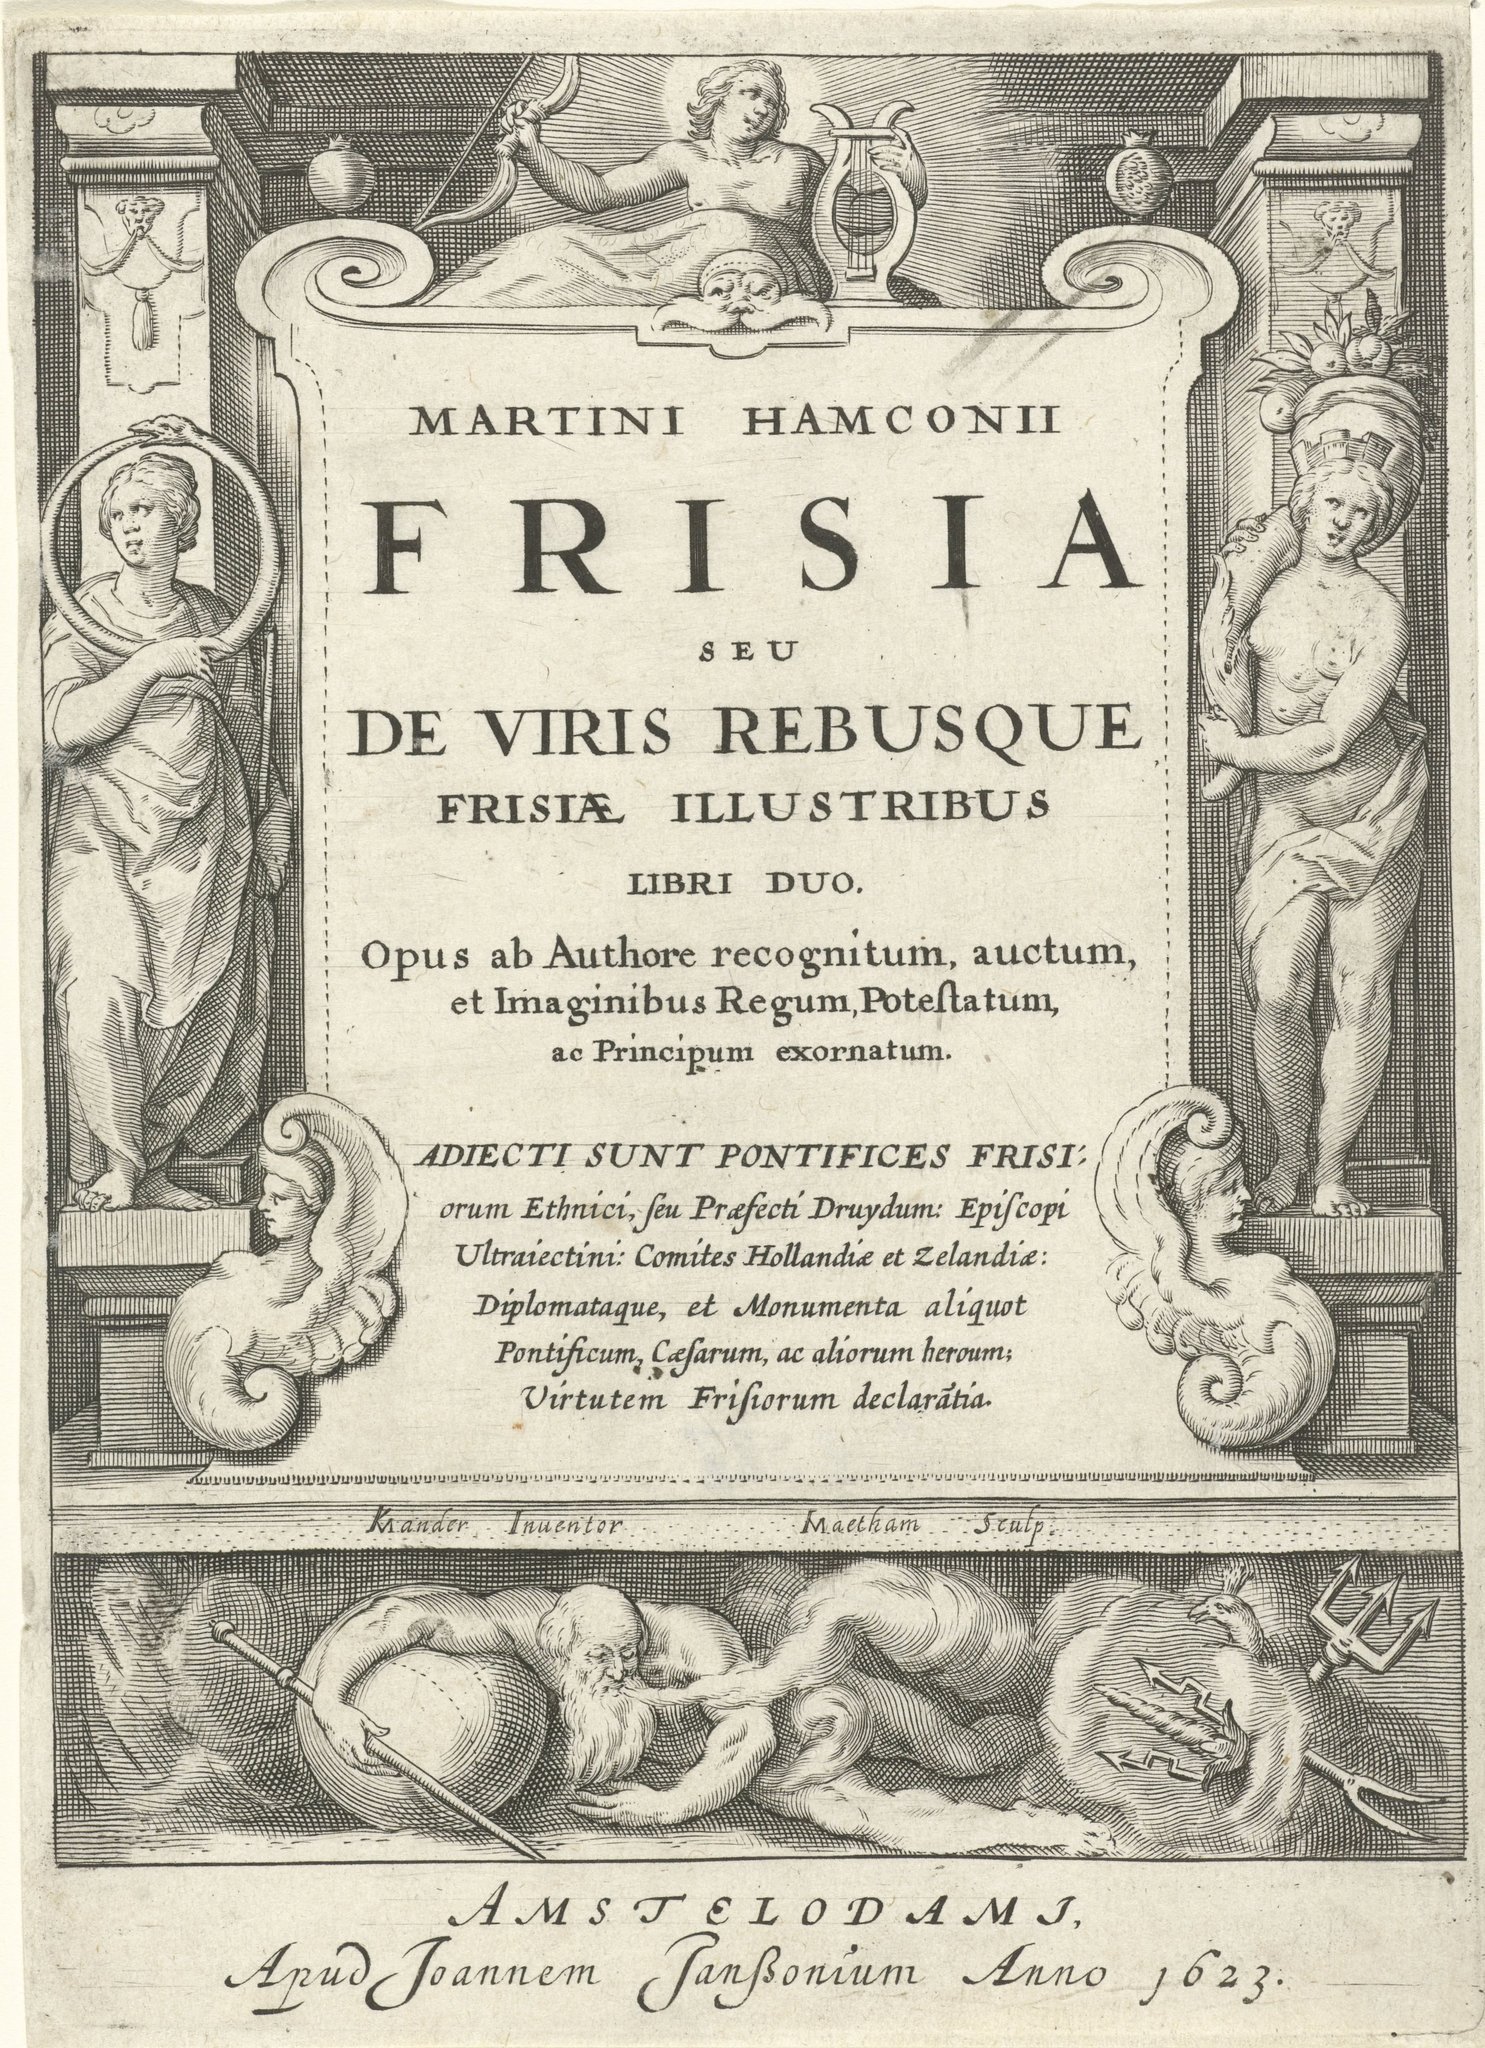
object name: print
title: Titelpagina voor: M. Hamconius, Frisia seu de viris rebusque Frisiae illustribus, 1623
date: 1623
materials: paper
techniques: engraving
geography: amsterdam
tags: 'natura' (allegorical figure or scene; or as diana of ephesus, with many breasts); 'natura' (ripa), specific aspects of saturn; saturn as patron, serpent ouroboros, specific aspects, allegorical aspects of apollo; apollo as patron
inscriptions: collector's mark: Lugt 2228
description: Titelpagina met links de personificatie van de eeuwigheid, met een slang die in zijn eigen staart bijt (ouroboros) en rechts de aarde of de natuur, met een hoorn des overvloeds en meerdere borsten waarmee ze meerdere kinderen kan zogen. Bovenaan Apollo, onderaan Saturnus.